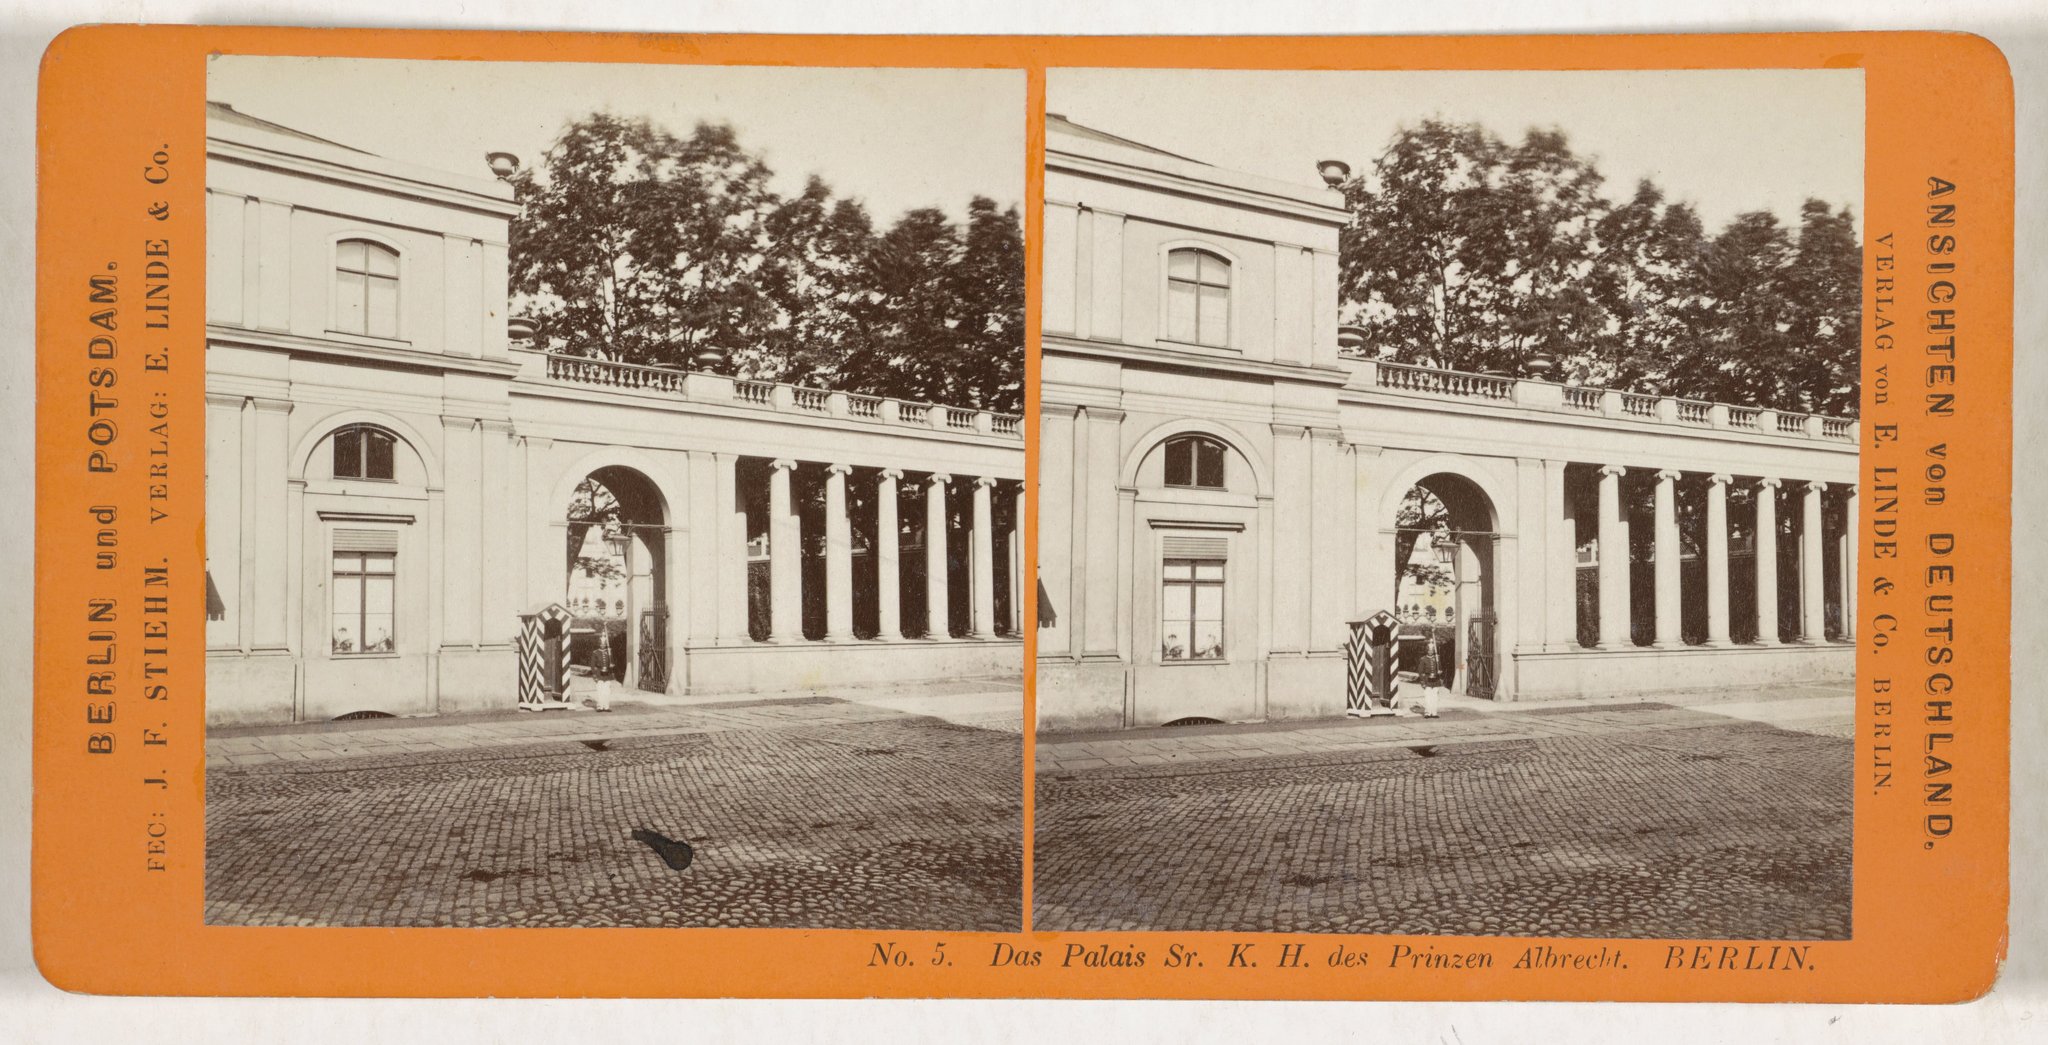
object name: stereograph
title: Prinz-Albrecht-Palais in Berlijn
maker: johann friedrich stiehm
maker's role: fotograaf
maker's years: 1826-1902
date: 1868-1870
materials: cardboard, paper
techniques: albumen print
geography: prinz-albrecht-palais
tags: palace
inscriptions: number: ‘No. 5.’